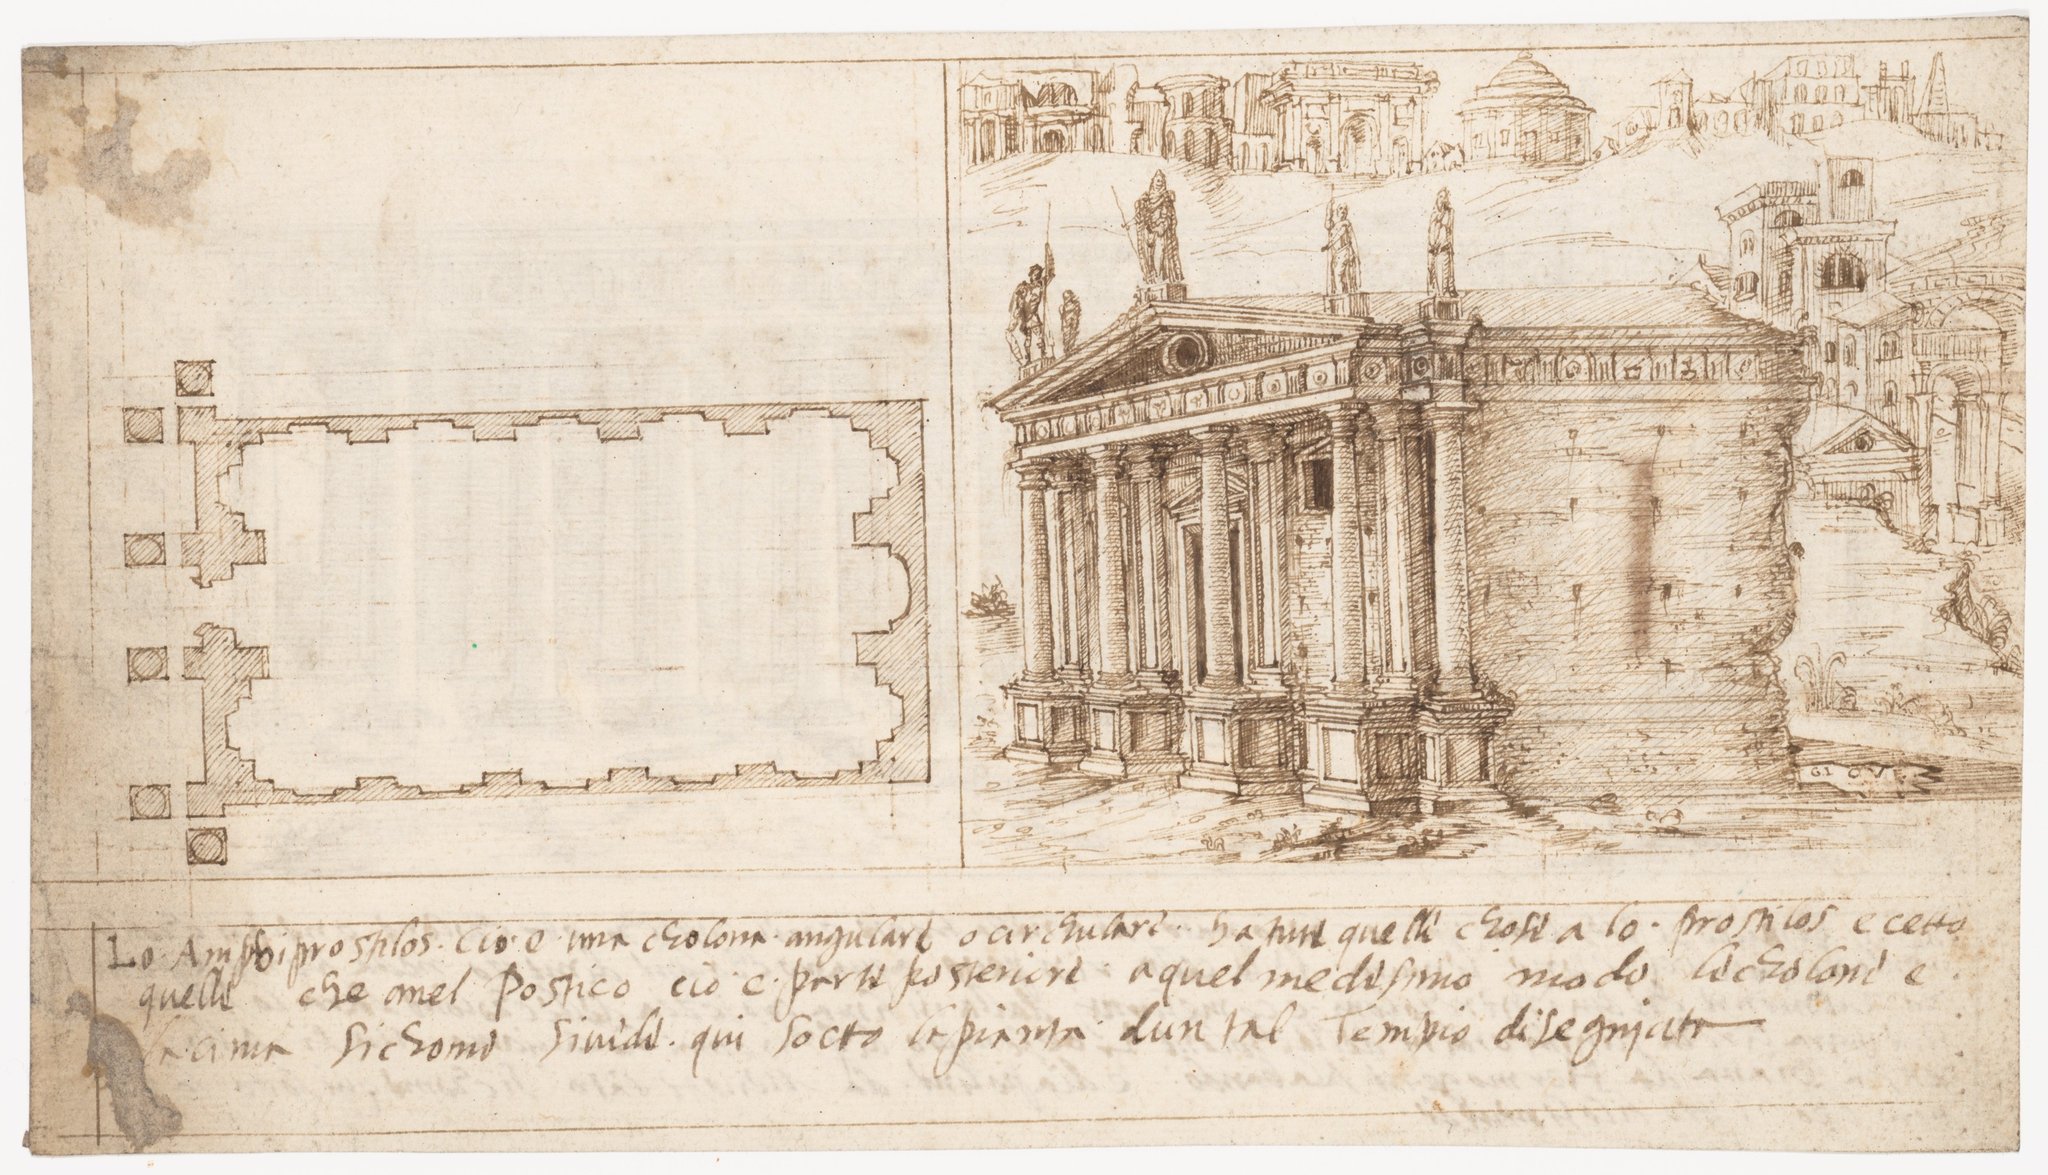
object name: drawing ornament architecture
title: Recto: Temple Types: Amphiprostyle (Vitruvius, Book 3, Chapter 2, no. 4); Verso: Temple Types: Pseudodipteral (Vitruvius, Book 3, Chapter 2, no. 6).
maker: sangallo family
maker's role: artist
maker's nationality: italian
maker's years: 1530-1545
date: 1530-1545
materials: ink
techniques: pen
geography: france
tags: architecture,temples